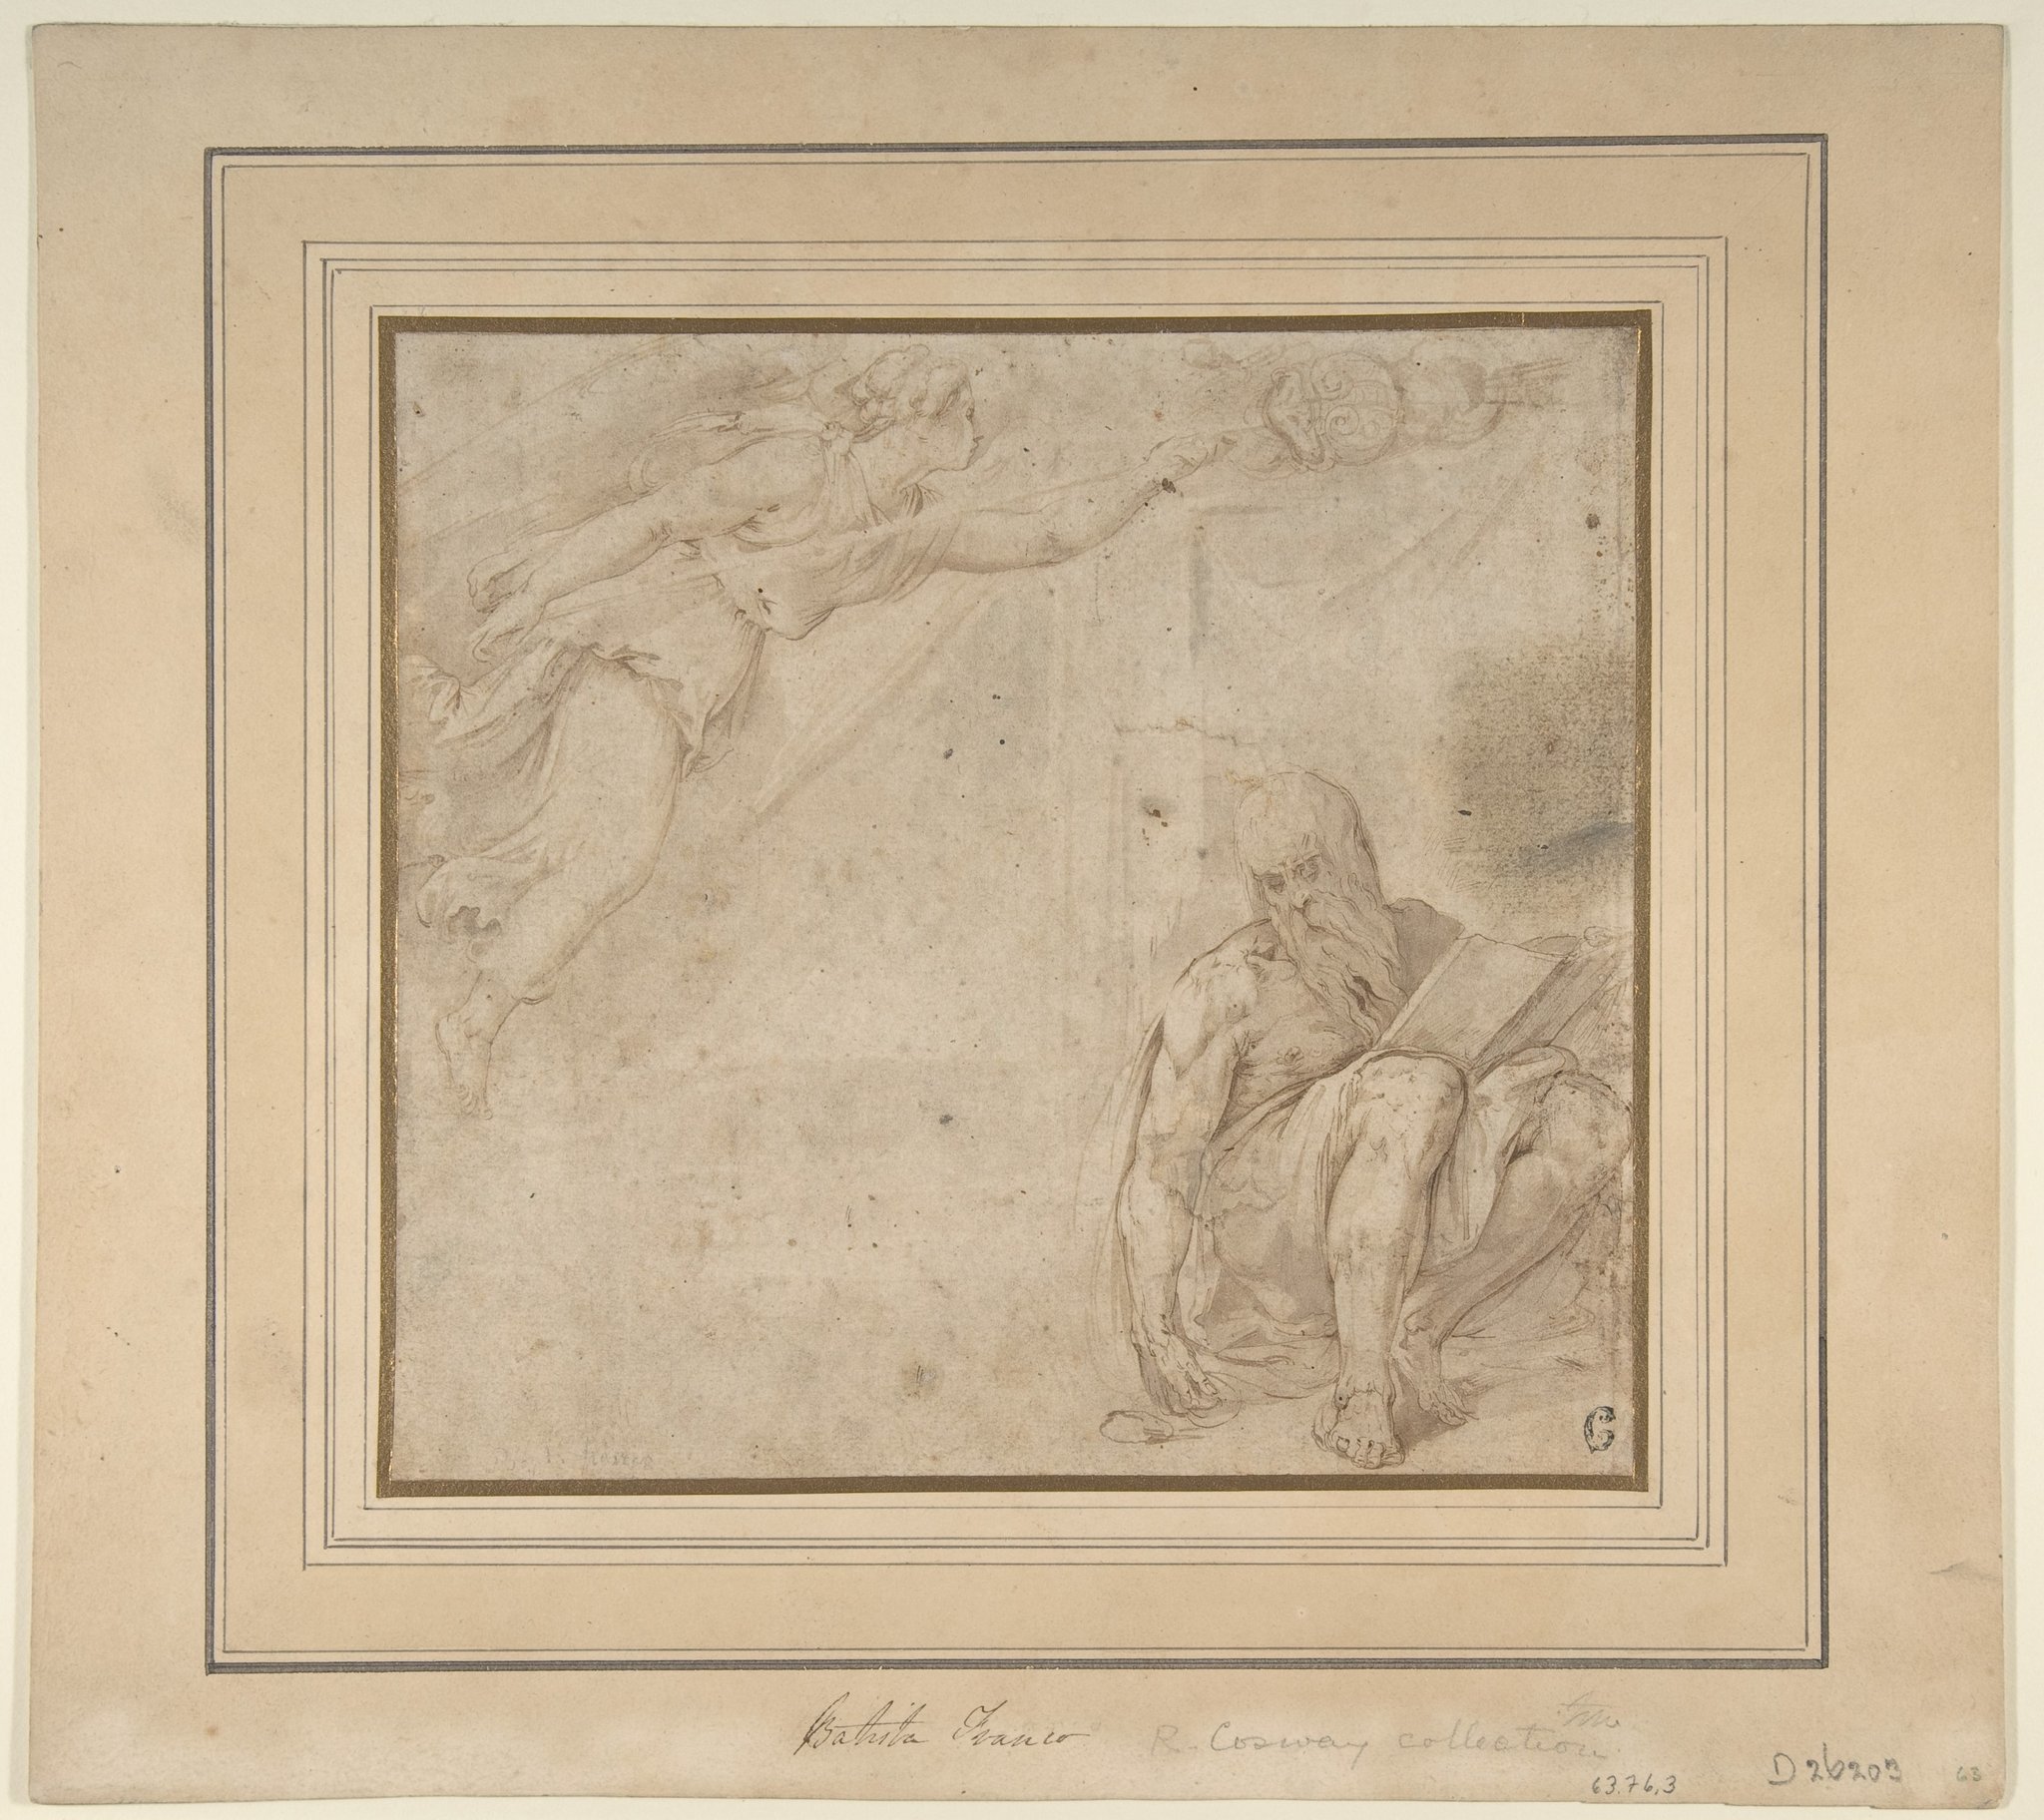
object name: drawing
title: Allegory with a Flying Victory and a Seated Bearded Man with a Book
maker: battista franco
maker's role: artist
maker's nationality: italian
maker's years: 1510-1561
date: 1510-1561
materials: ink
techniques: brush, pen, wash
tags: books,men